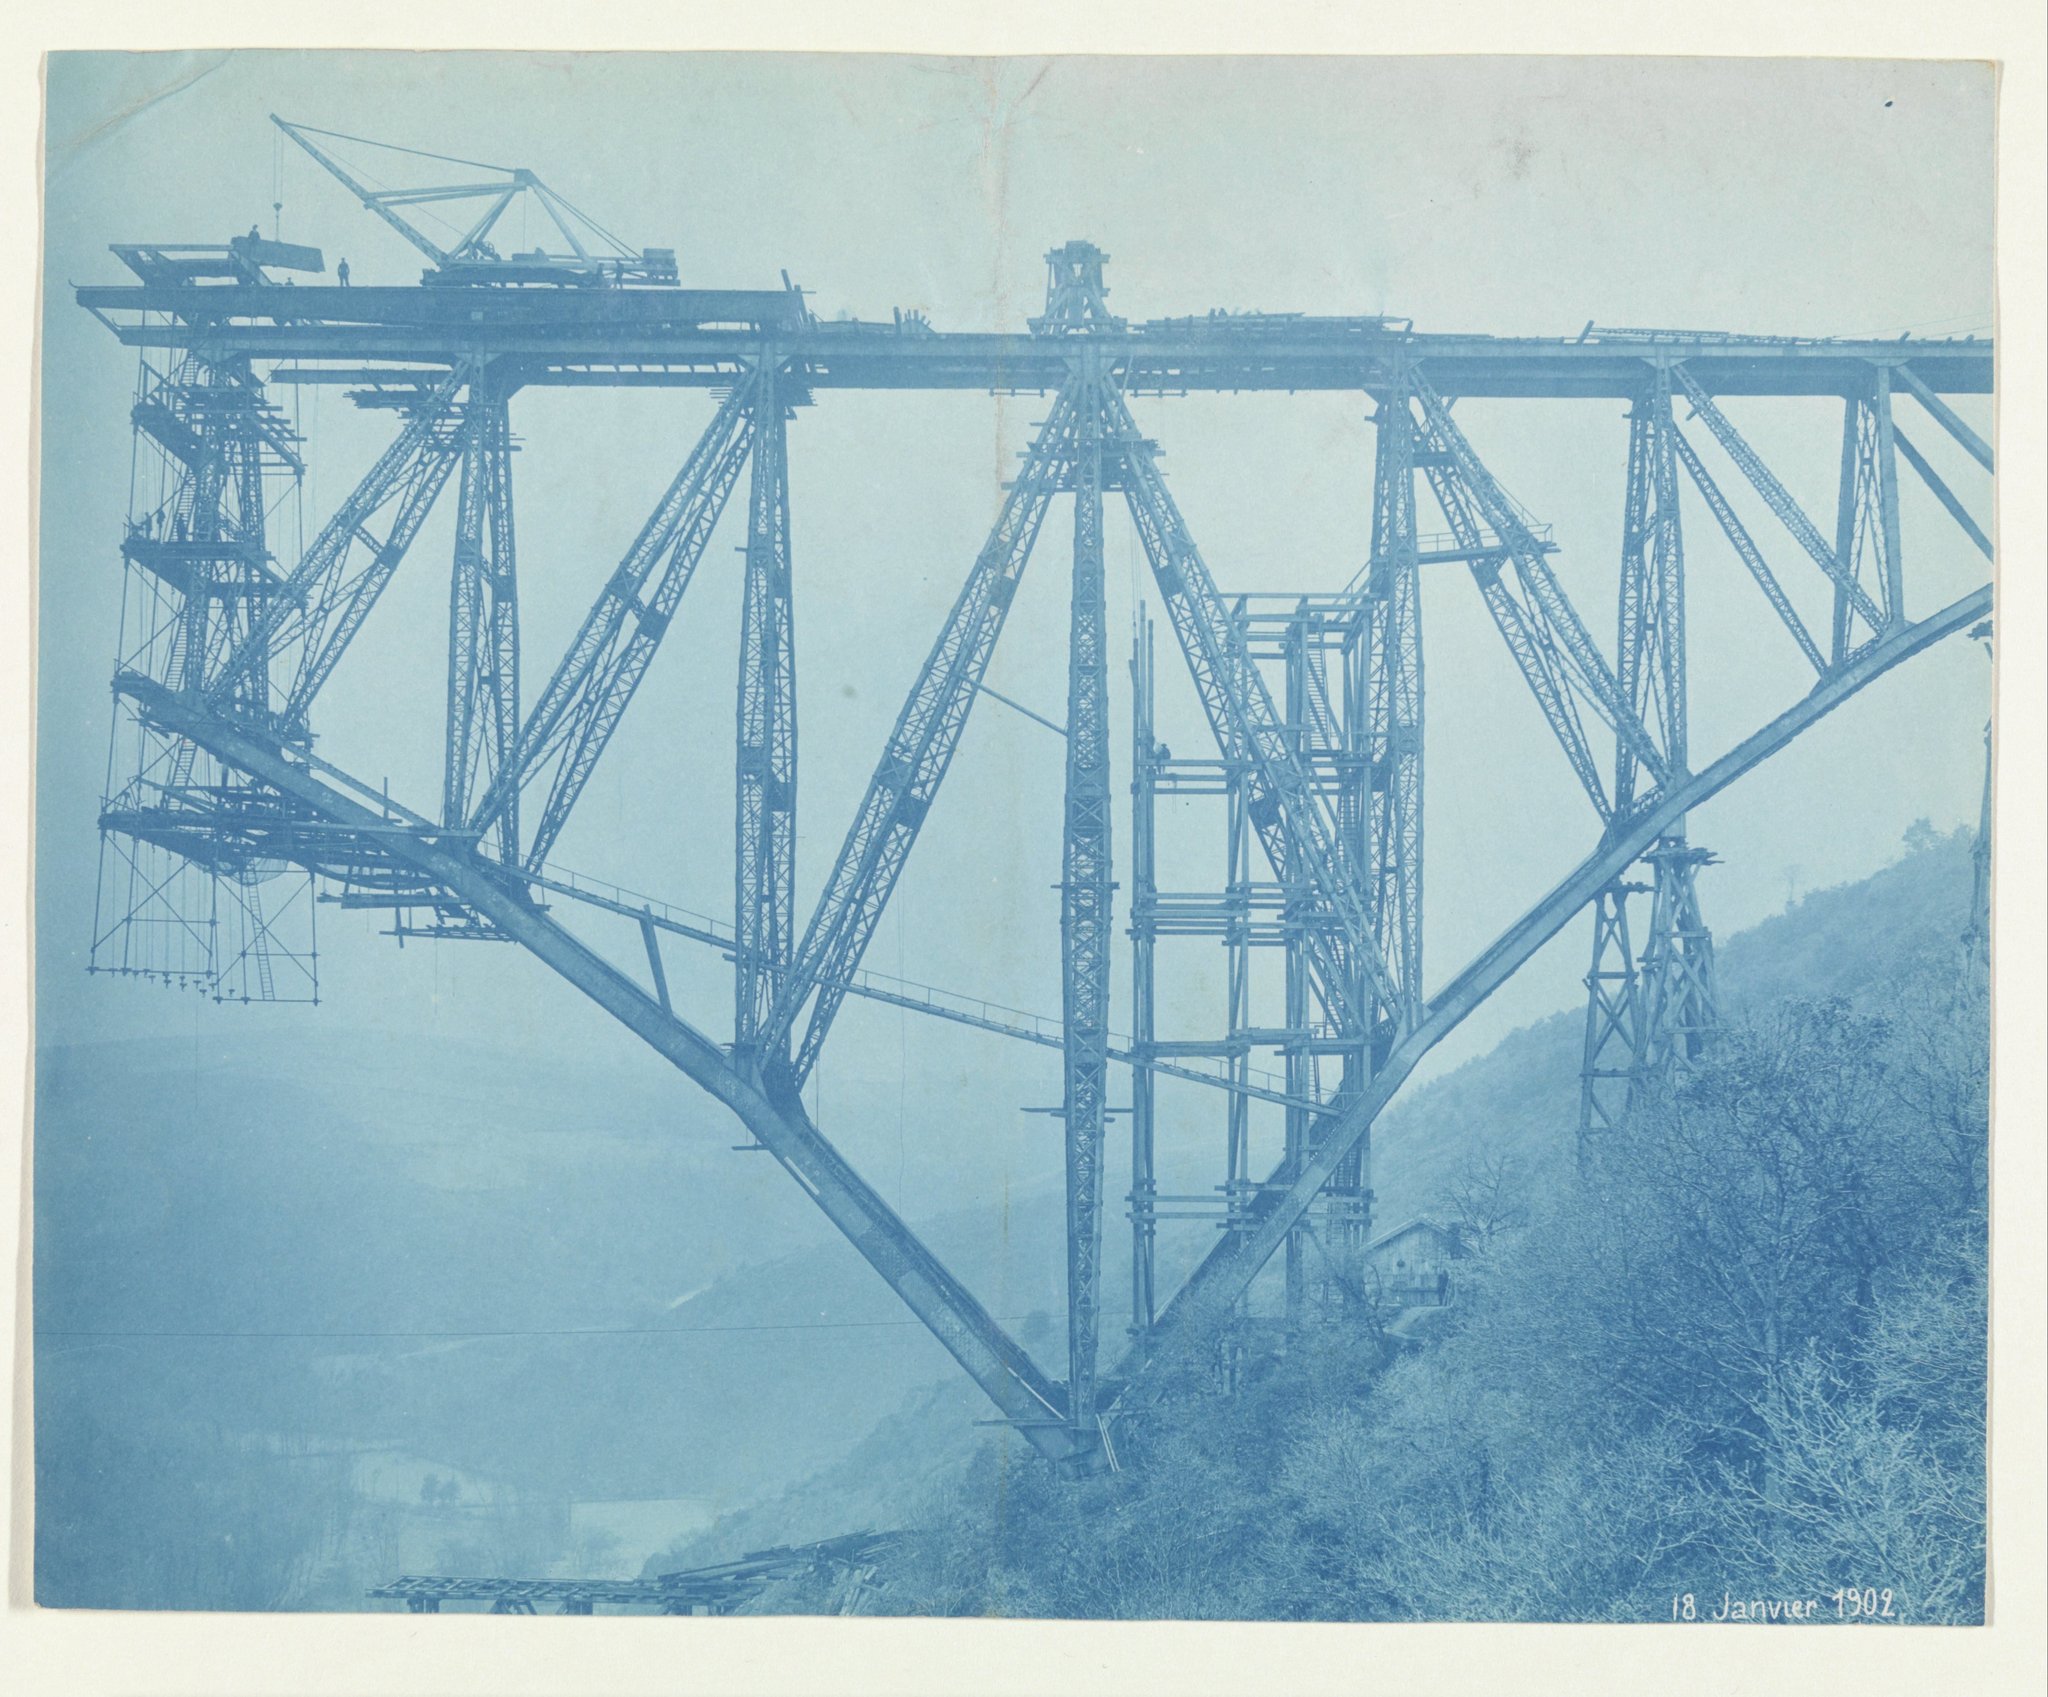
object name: photograph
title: Aanleg van het Viaur Viaduct in Frankrijk door de Societé de Construction des Battignolles, 18 januari 1902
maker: Anonymous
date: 1902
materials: photographic support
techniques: cyanotype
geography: france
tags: viaduct, making the overground structures (~ building activities)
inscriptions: inscription: ‘Viaduc sur le Viaur // Demi-pont Rodez // Montage de 3e panneau de la travée centrale // Vue des filets de securité tendus a la partie inférieure // 18 janvier 1902’